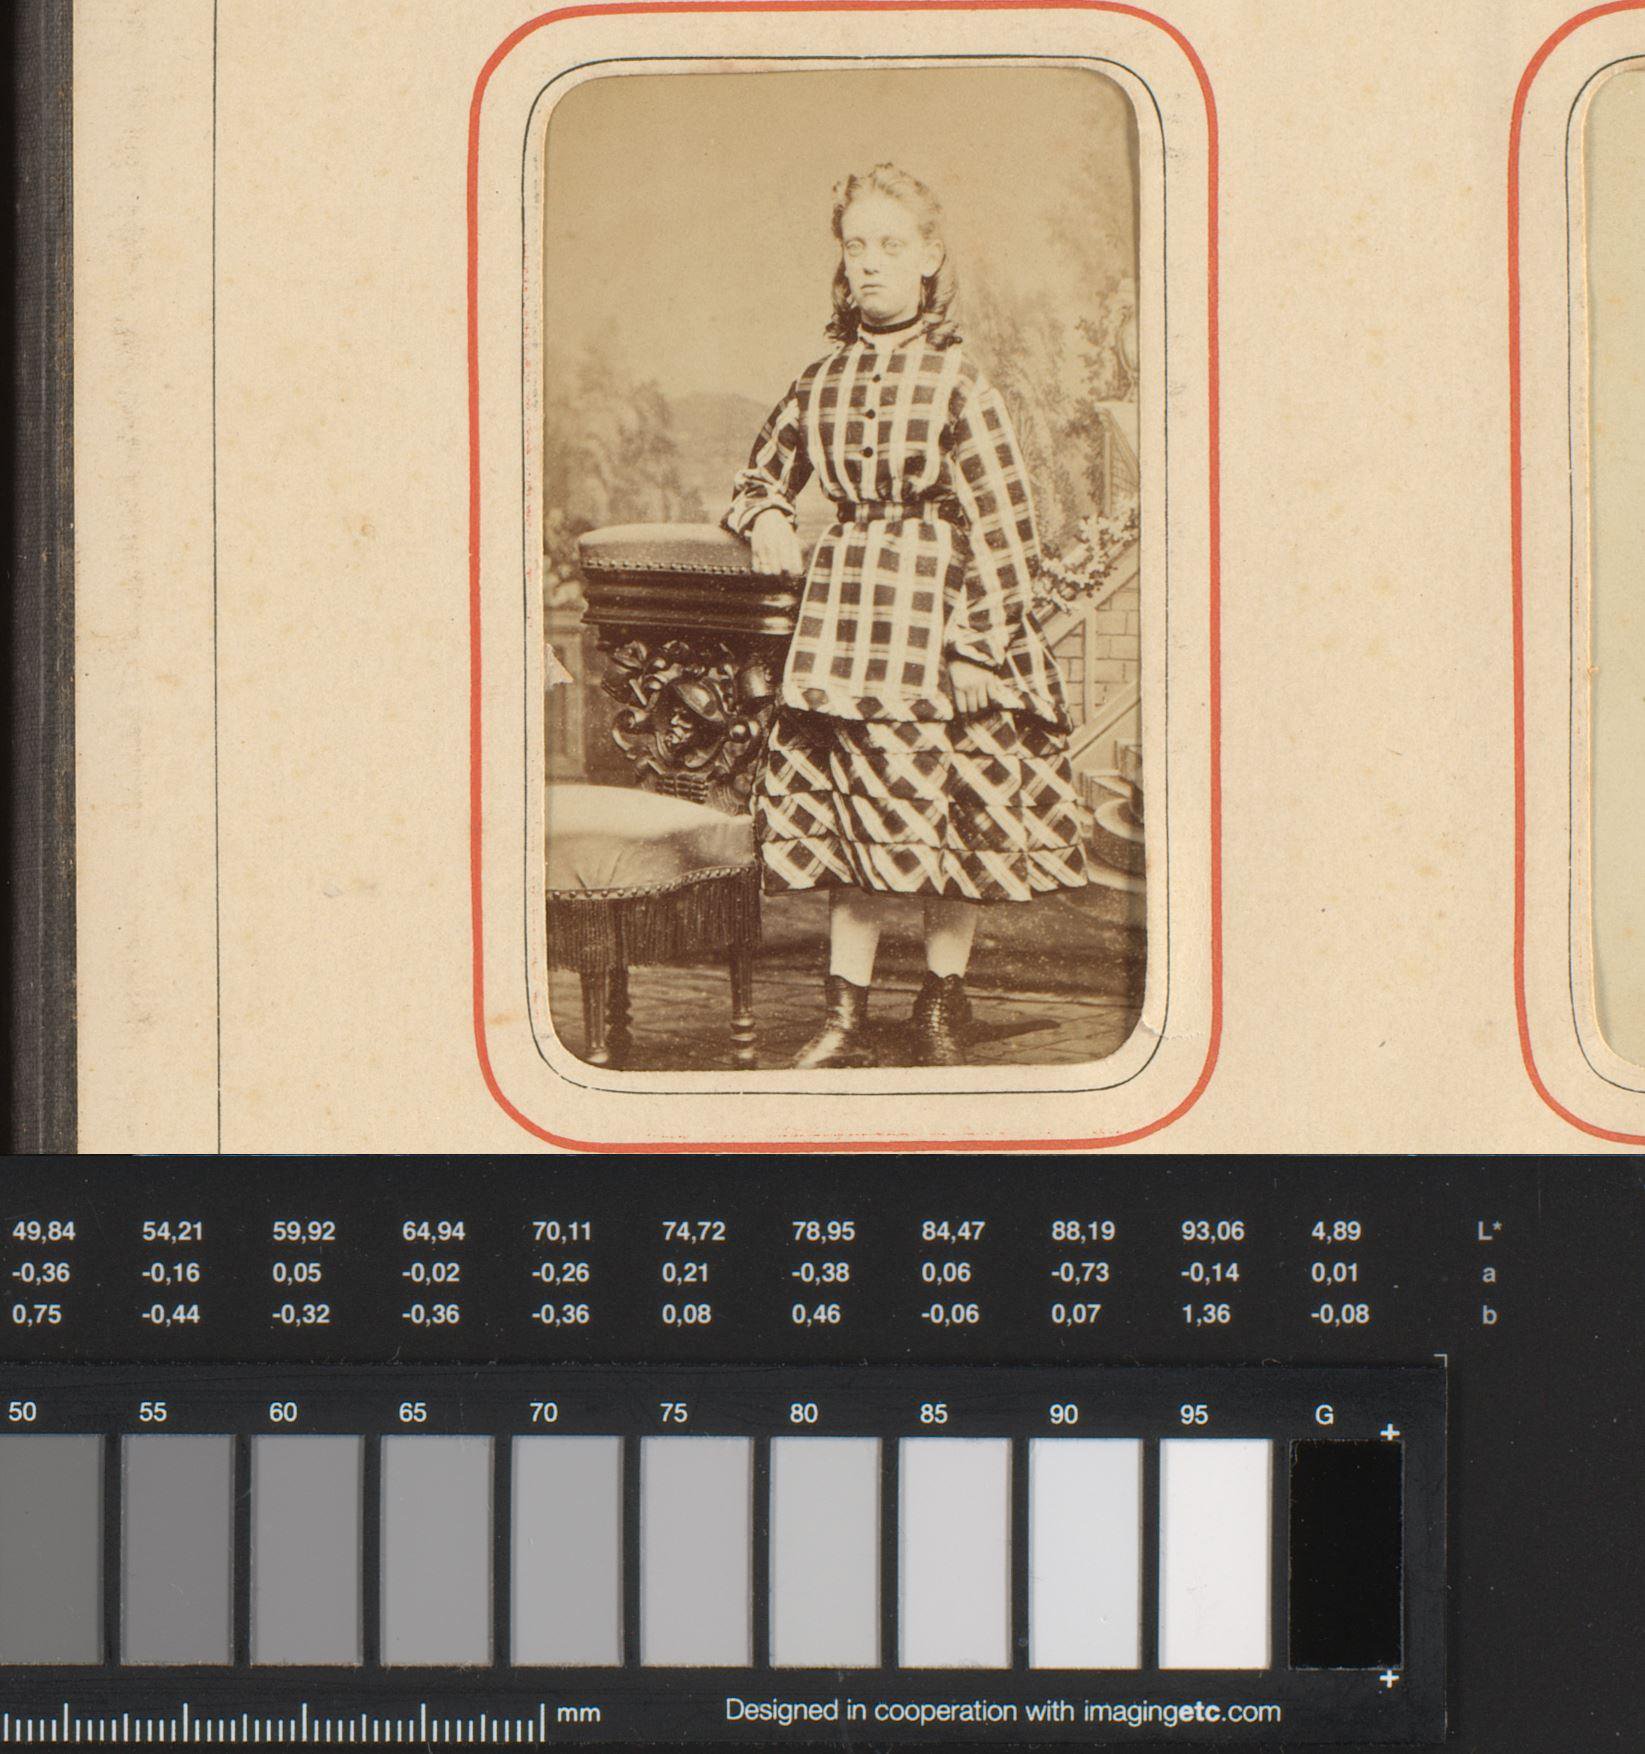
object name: carte de visite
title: Portret van een onbekend meisje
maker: Anonymous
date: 1870-1890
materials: cardboard, paper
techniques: albumen print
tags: anonymous historical person portrayed - bb - woman